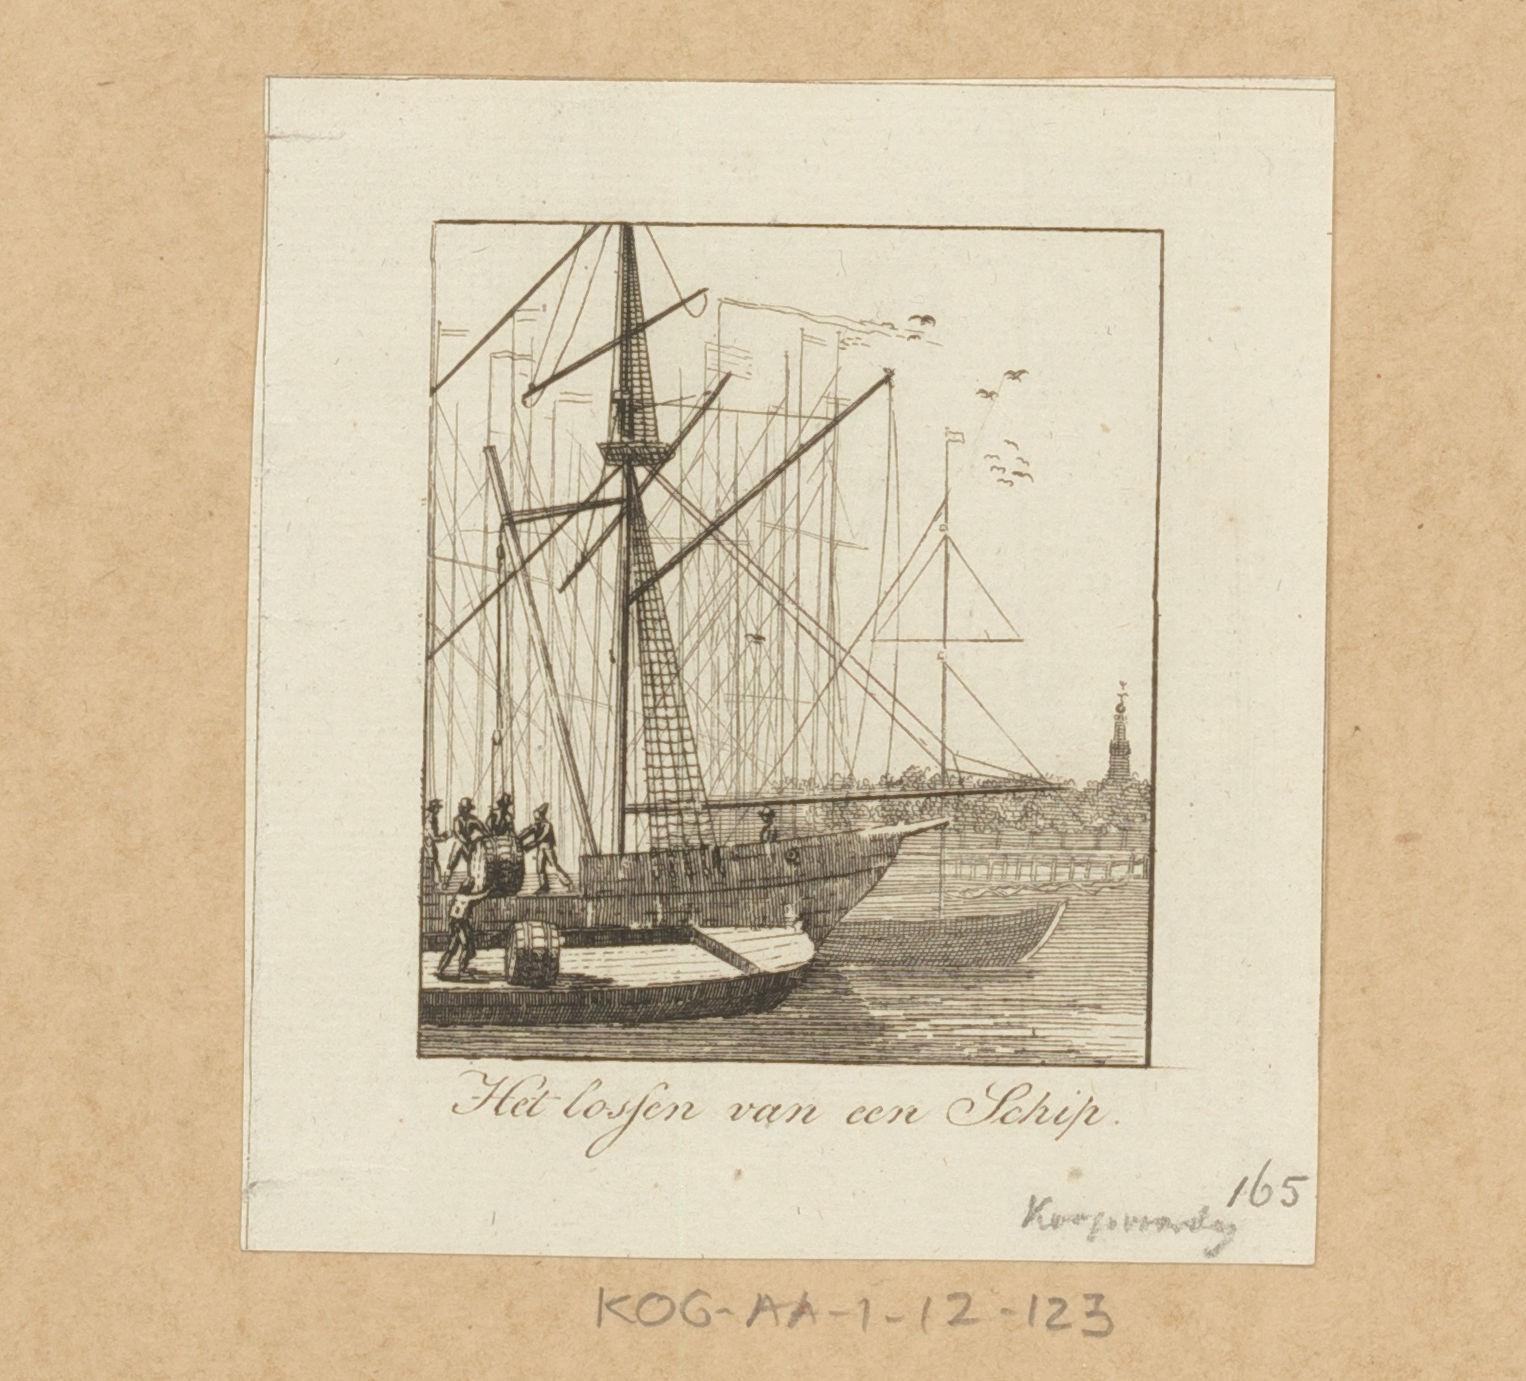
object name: print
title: Het lossen van een Schip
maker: Anonymous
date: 1800-1849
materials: paper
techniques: etching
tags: harbour, sailing-ship, sailing-boat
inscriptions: collector's mark: Lugt 1641, stamp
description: Onderwerpsrubrieken binnen de Atlas Zeden en Gewoonten: Handel, Nijverheid en Verkeer, Scheepsvaart.